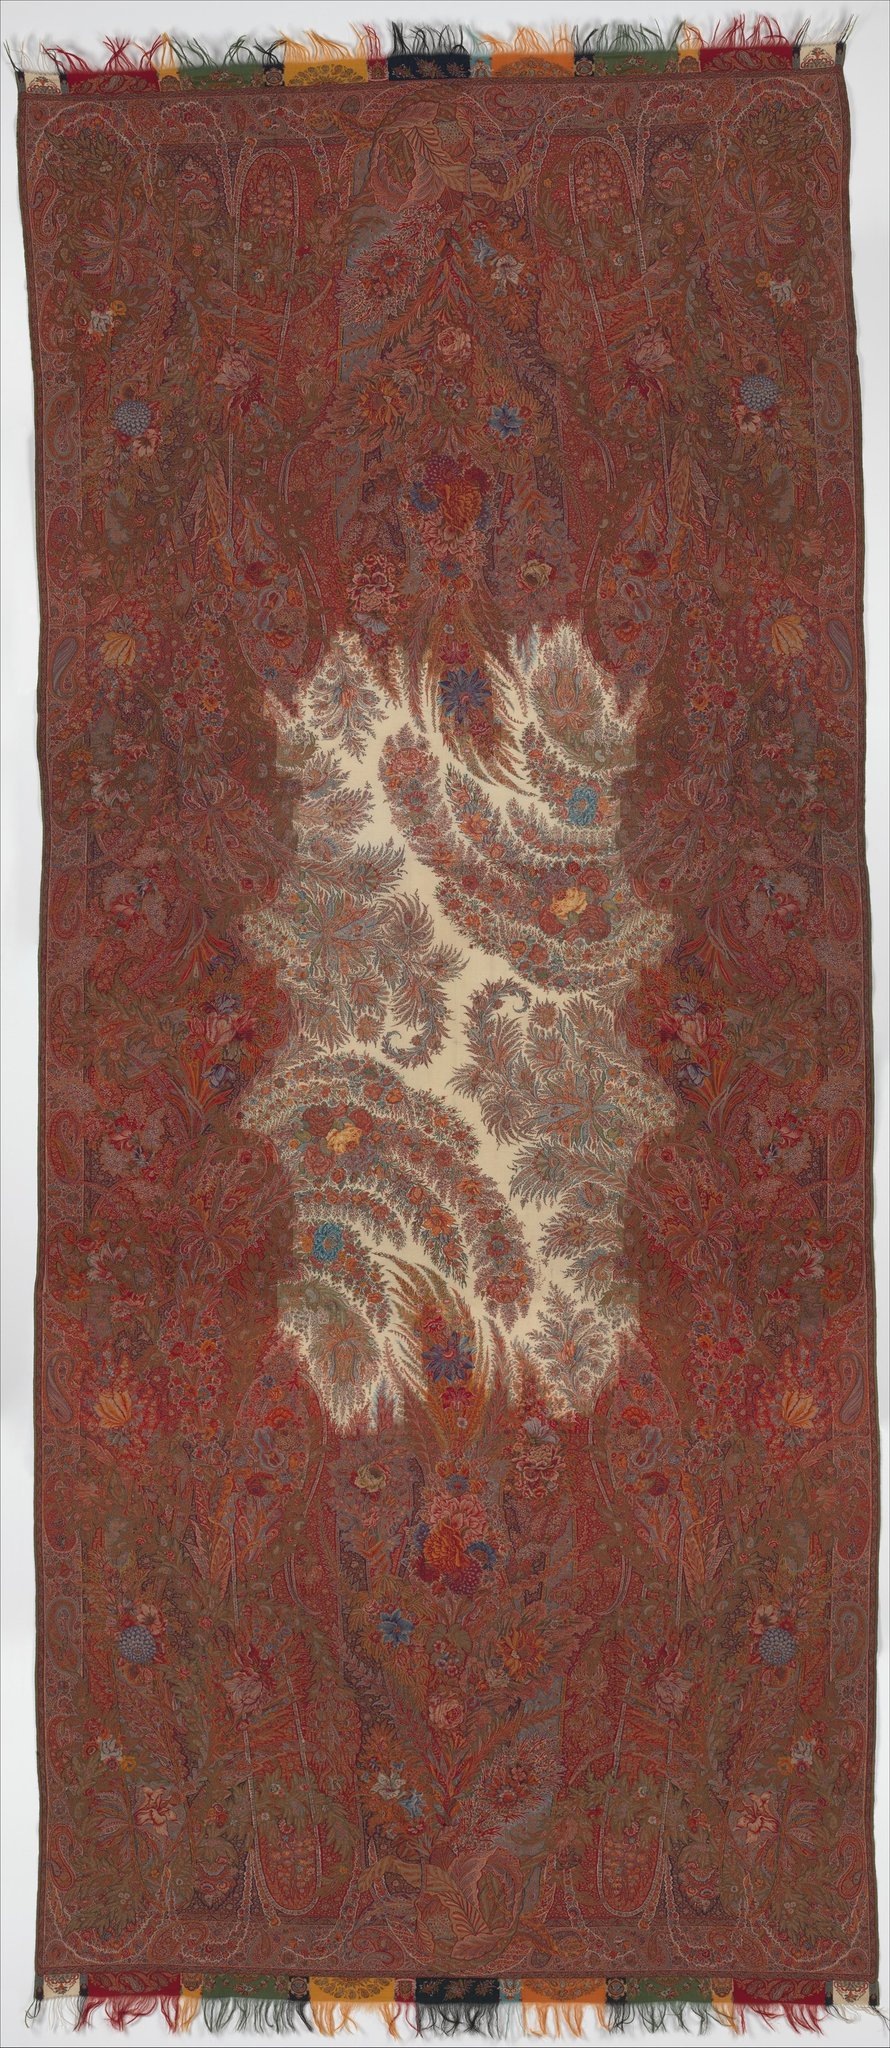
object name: shawl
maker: deneirouse and boisglavy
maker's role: manufactory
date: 1849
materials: silk